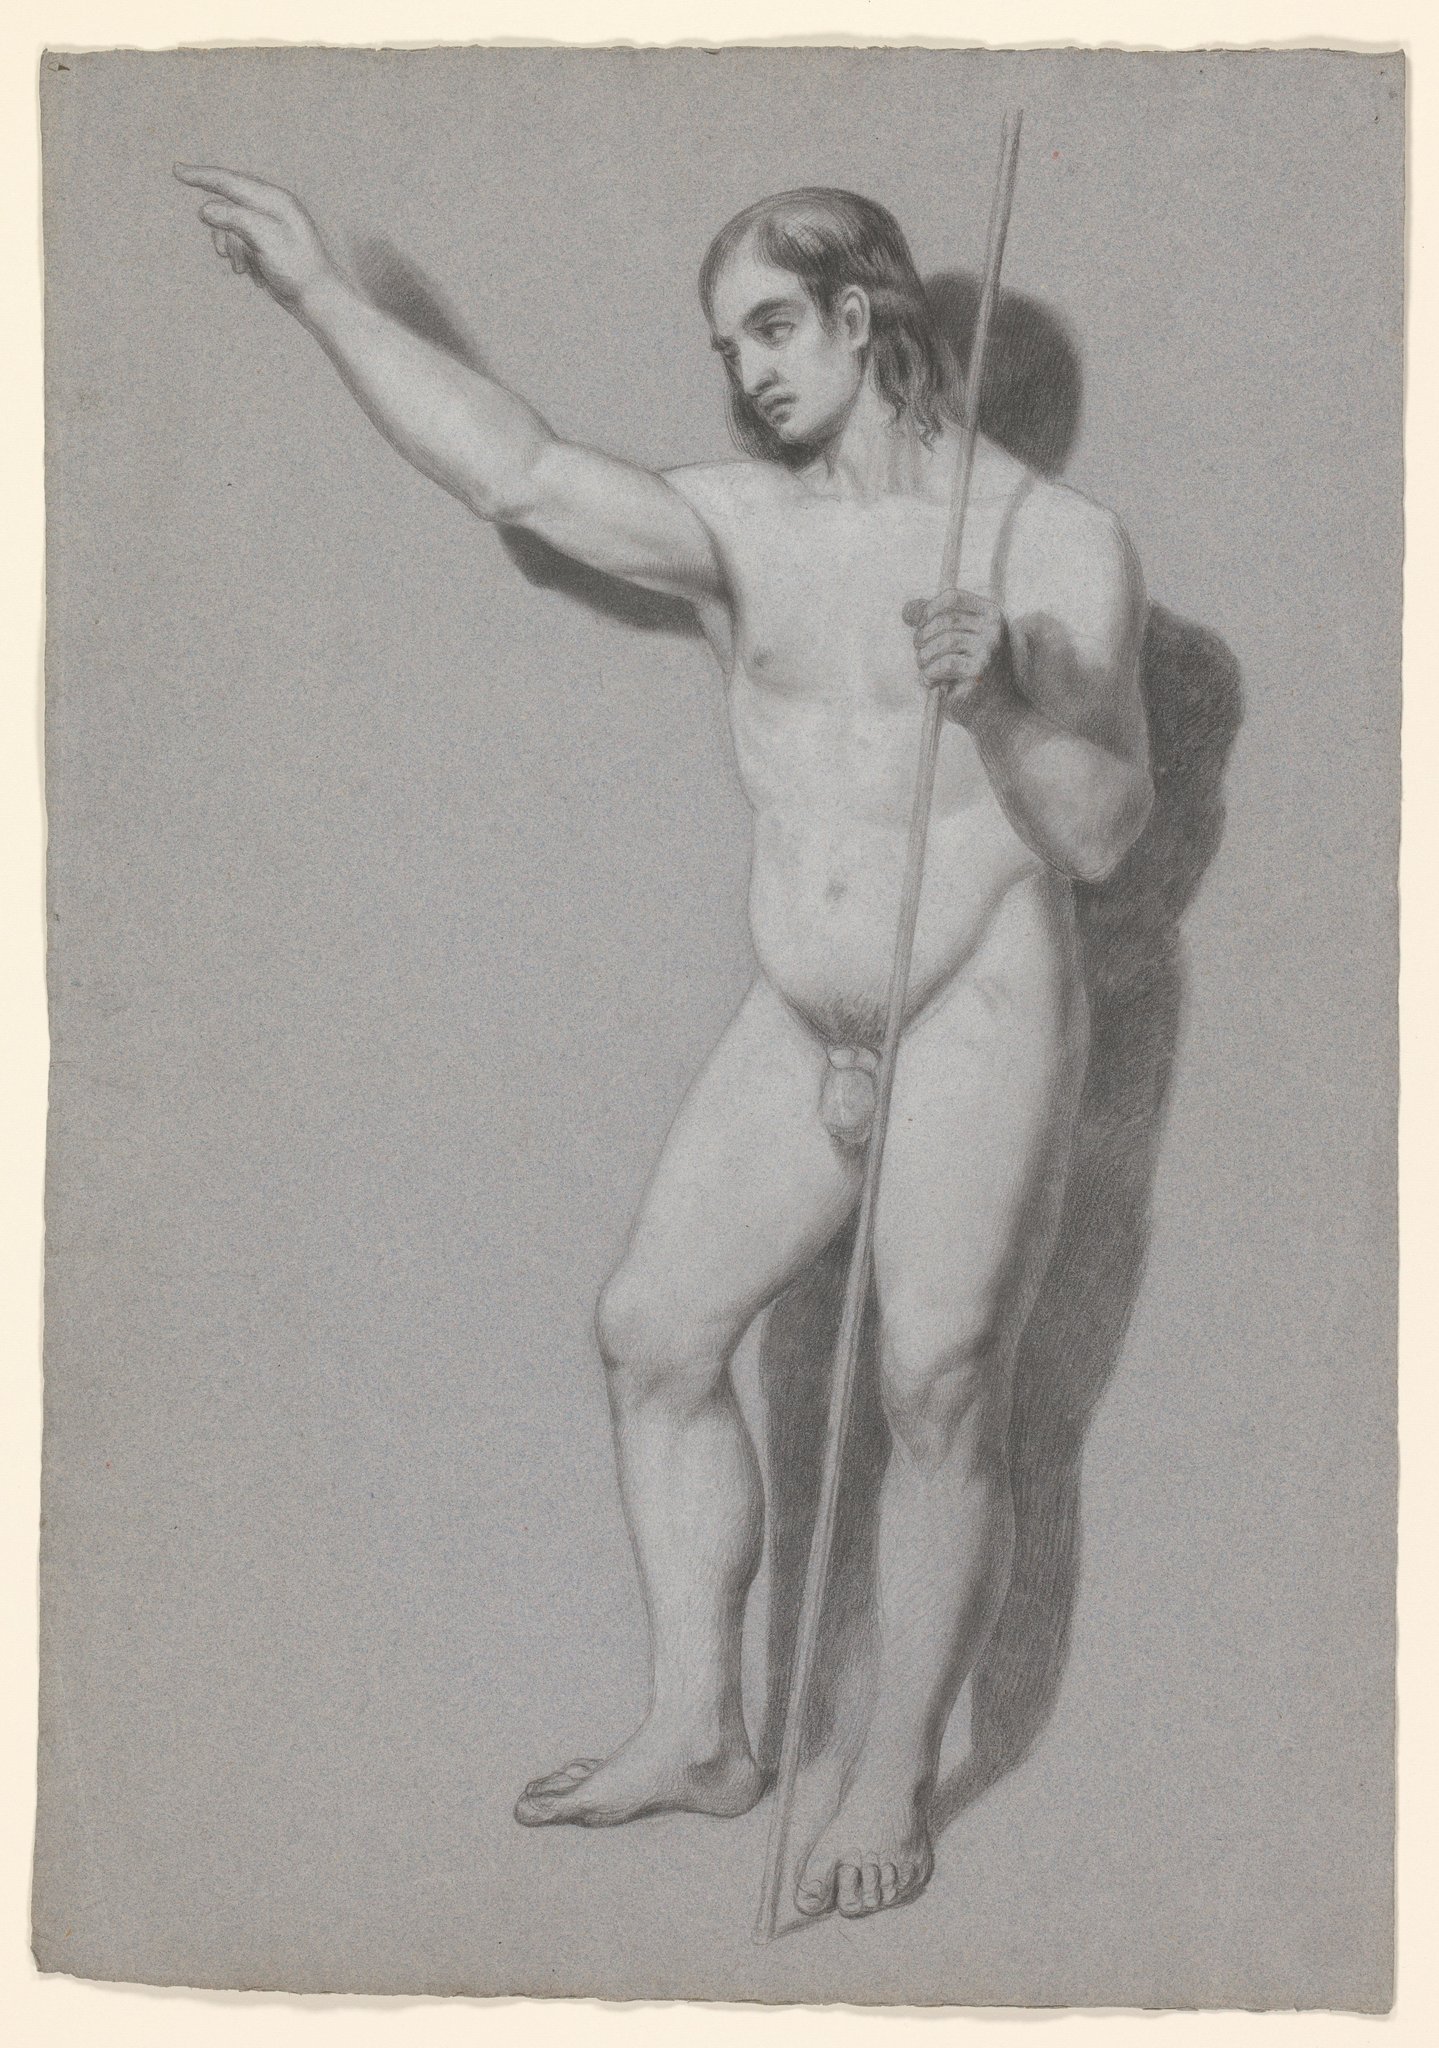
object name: drawing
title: Staand mannelijk naakt met staf en opgeheven rechterarm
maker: Anonymous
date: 1700-1800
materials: chalk, paper